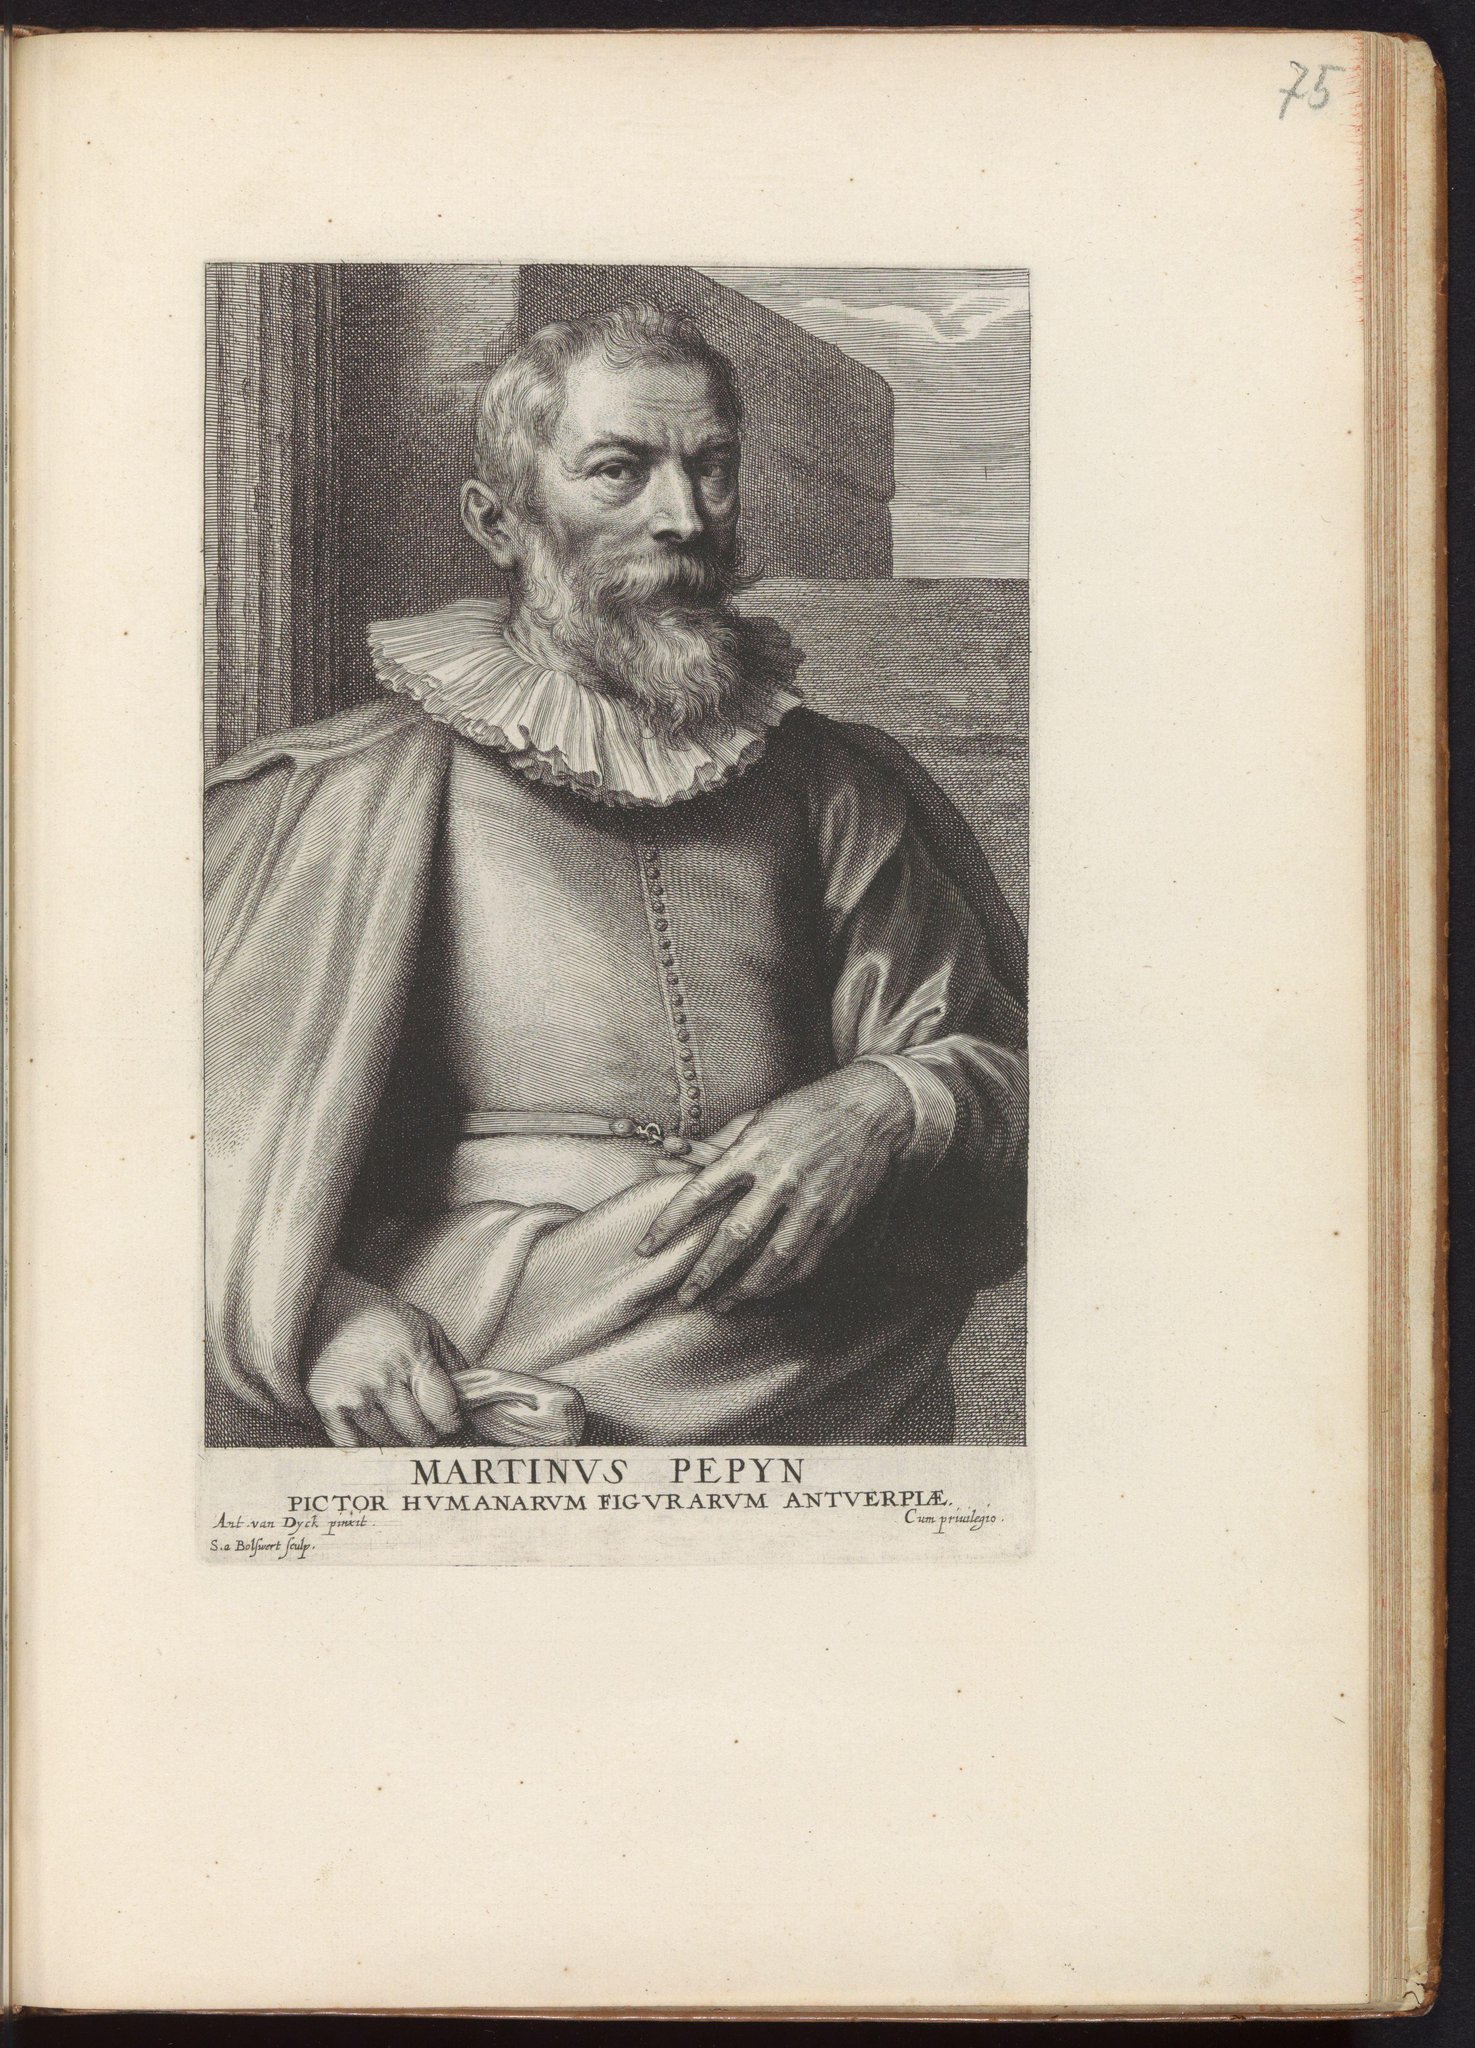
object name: print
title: Iconographie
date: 1630-1641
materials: paper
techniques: engraving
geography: antwerp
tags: artist, historical persons, portrait, self-portrait of painter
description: Deze prent maakt deel uit van een album.